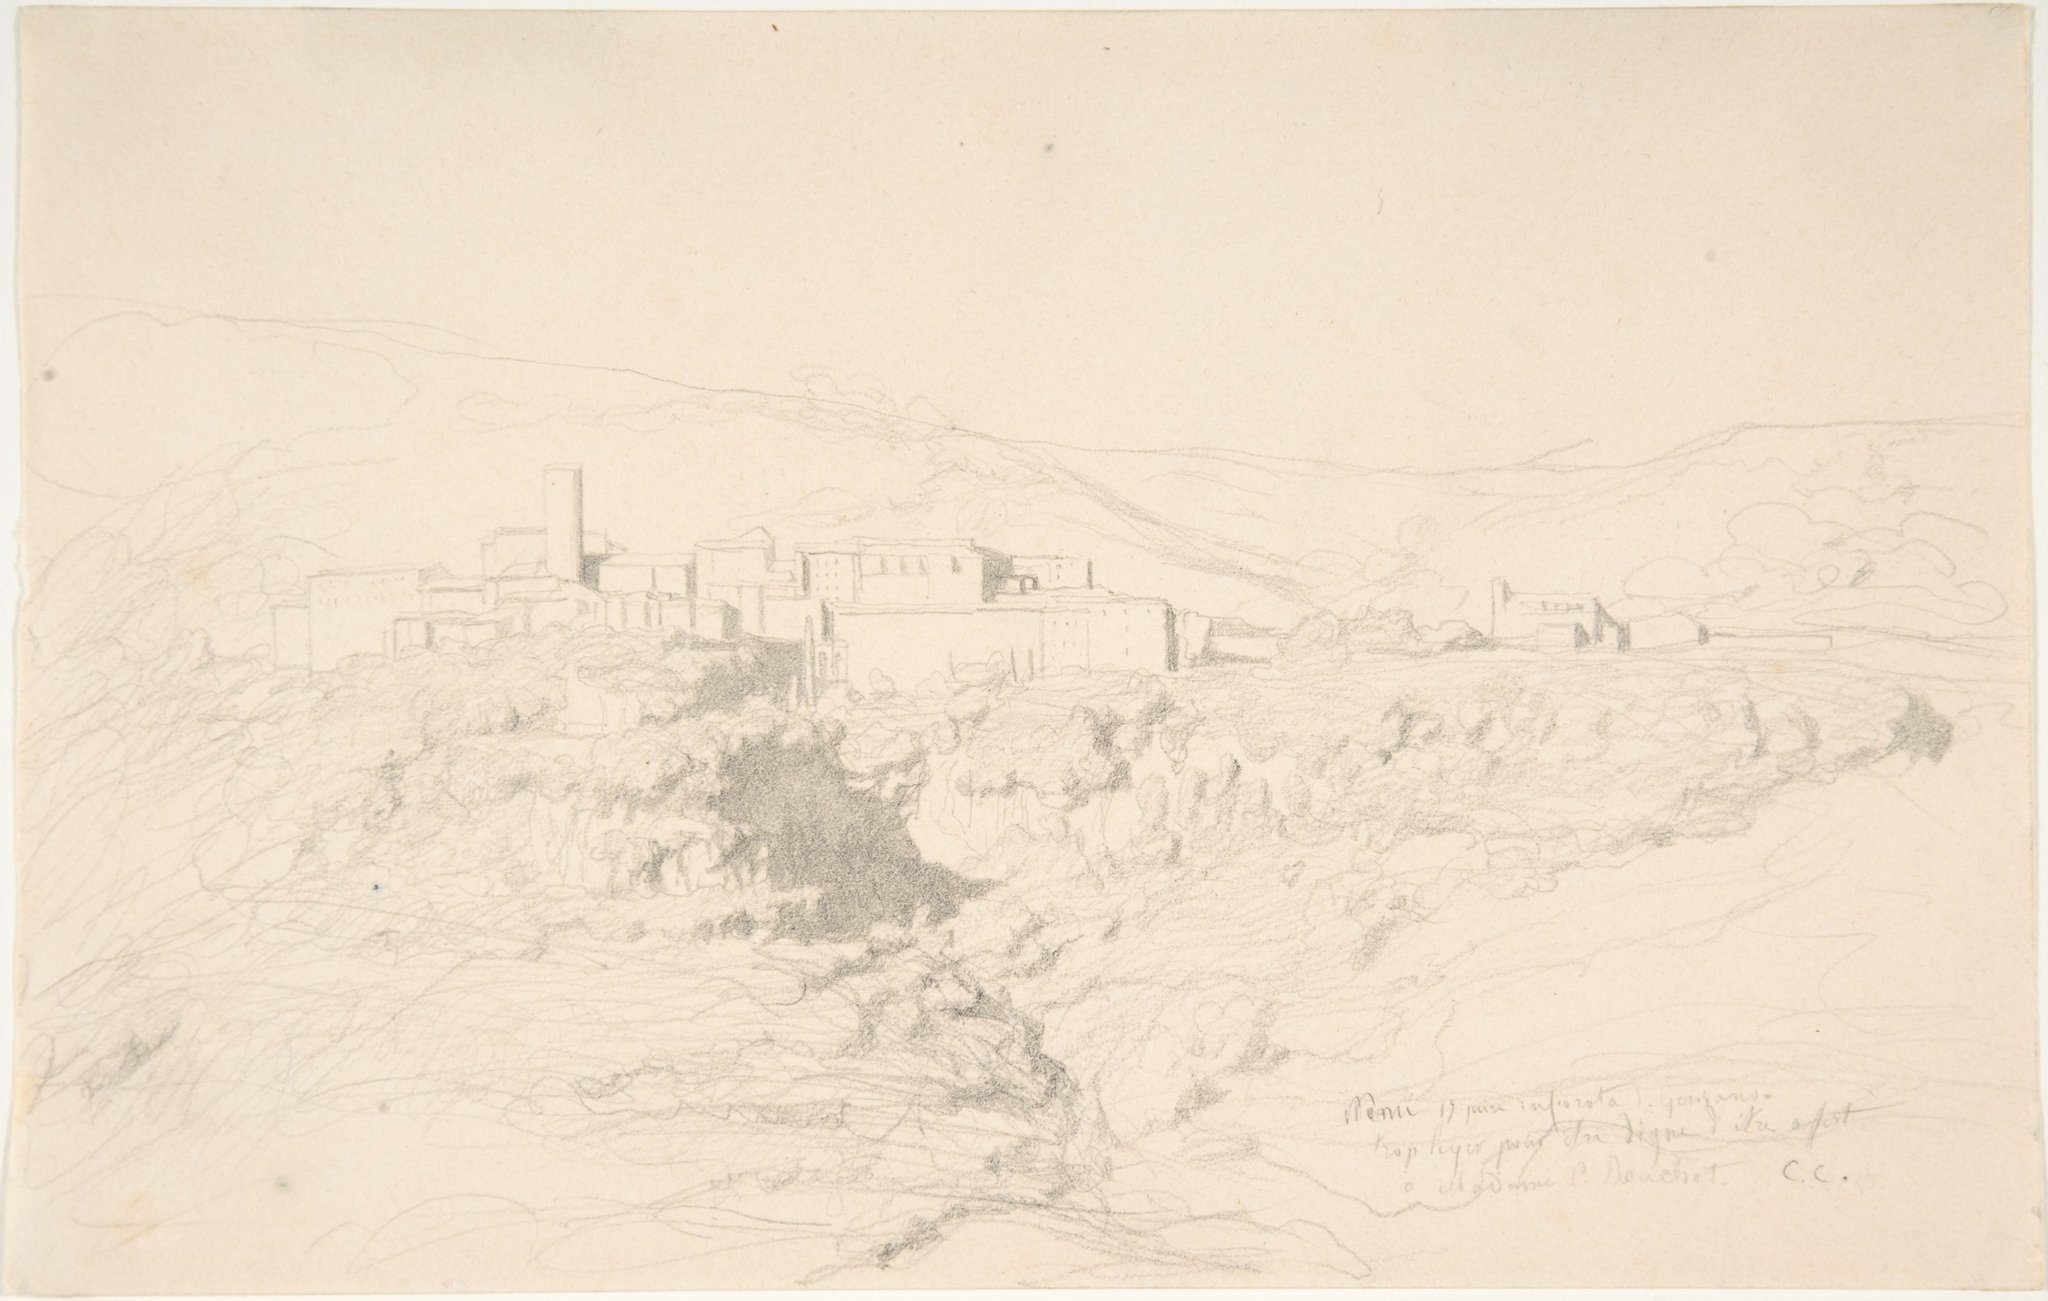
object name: drawing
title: View of Nemi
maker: jean-baptiste-camille corot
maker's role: artist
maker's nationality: french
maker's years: 1796-1875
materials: graphite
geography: france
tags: houses,landscapes